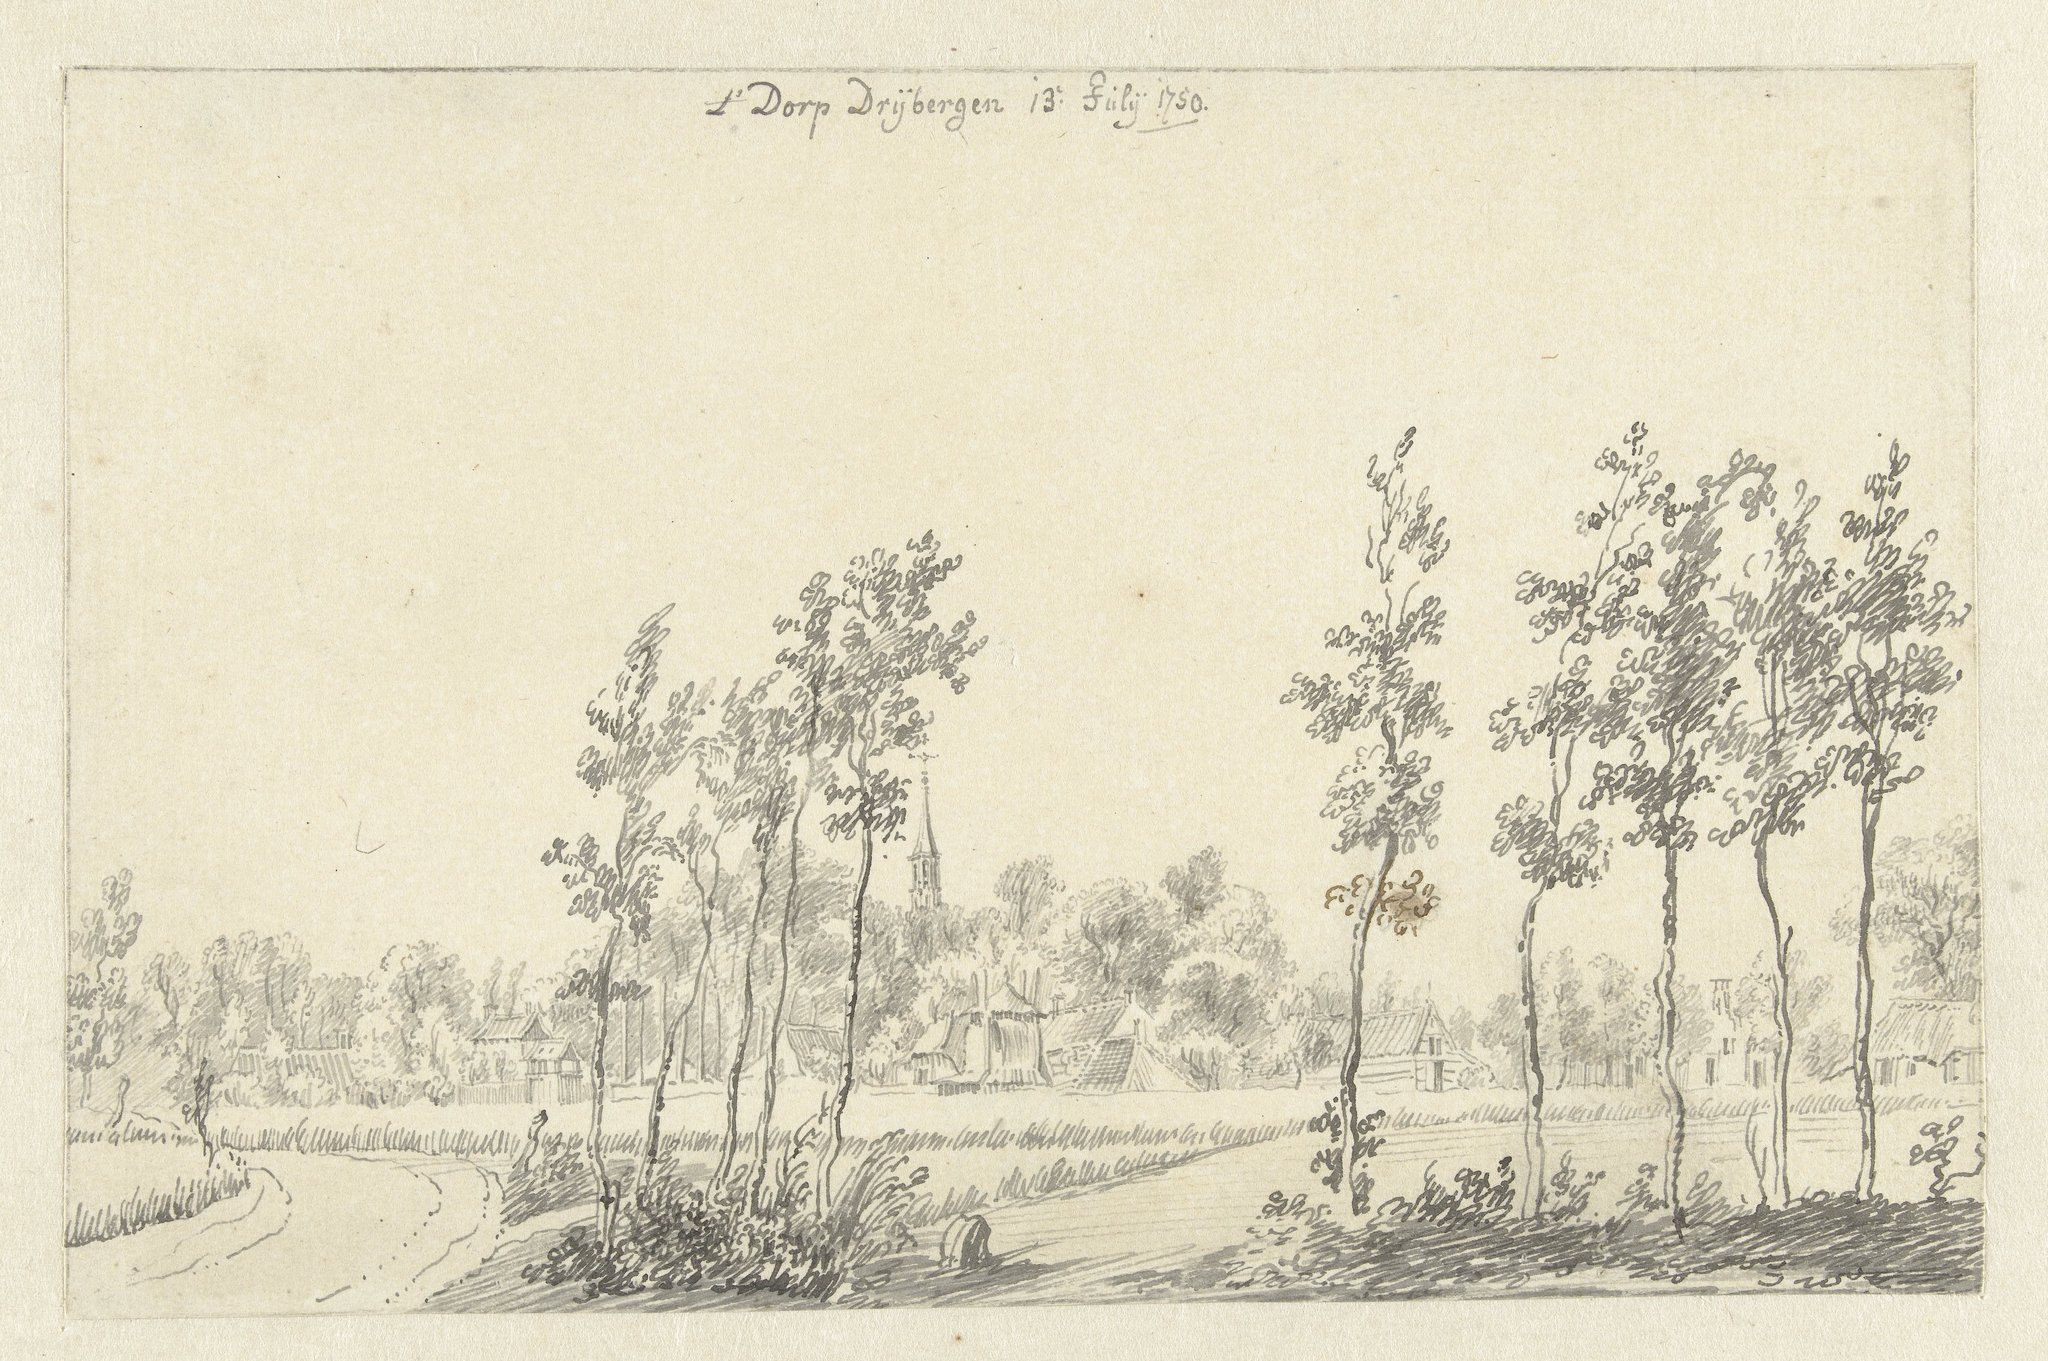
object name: drawing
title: Gezicht op het dorp Driebergen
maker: jan de beijer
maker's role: draughtsman, print maker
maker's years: 1703-1780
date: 1750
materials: ink, paper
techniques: brush, pen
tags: prospect of city, town panorama, silhouette of city